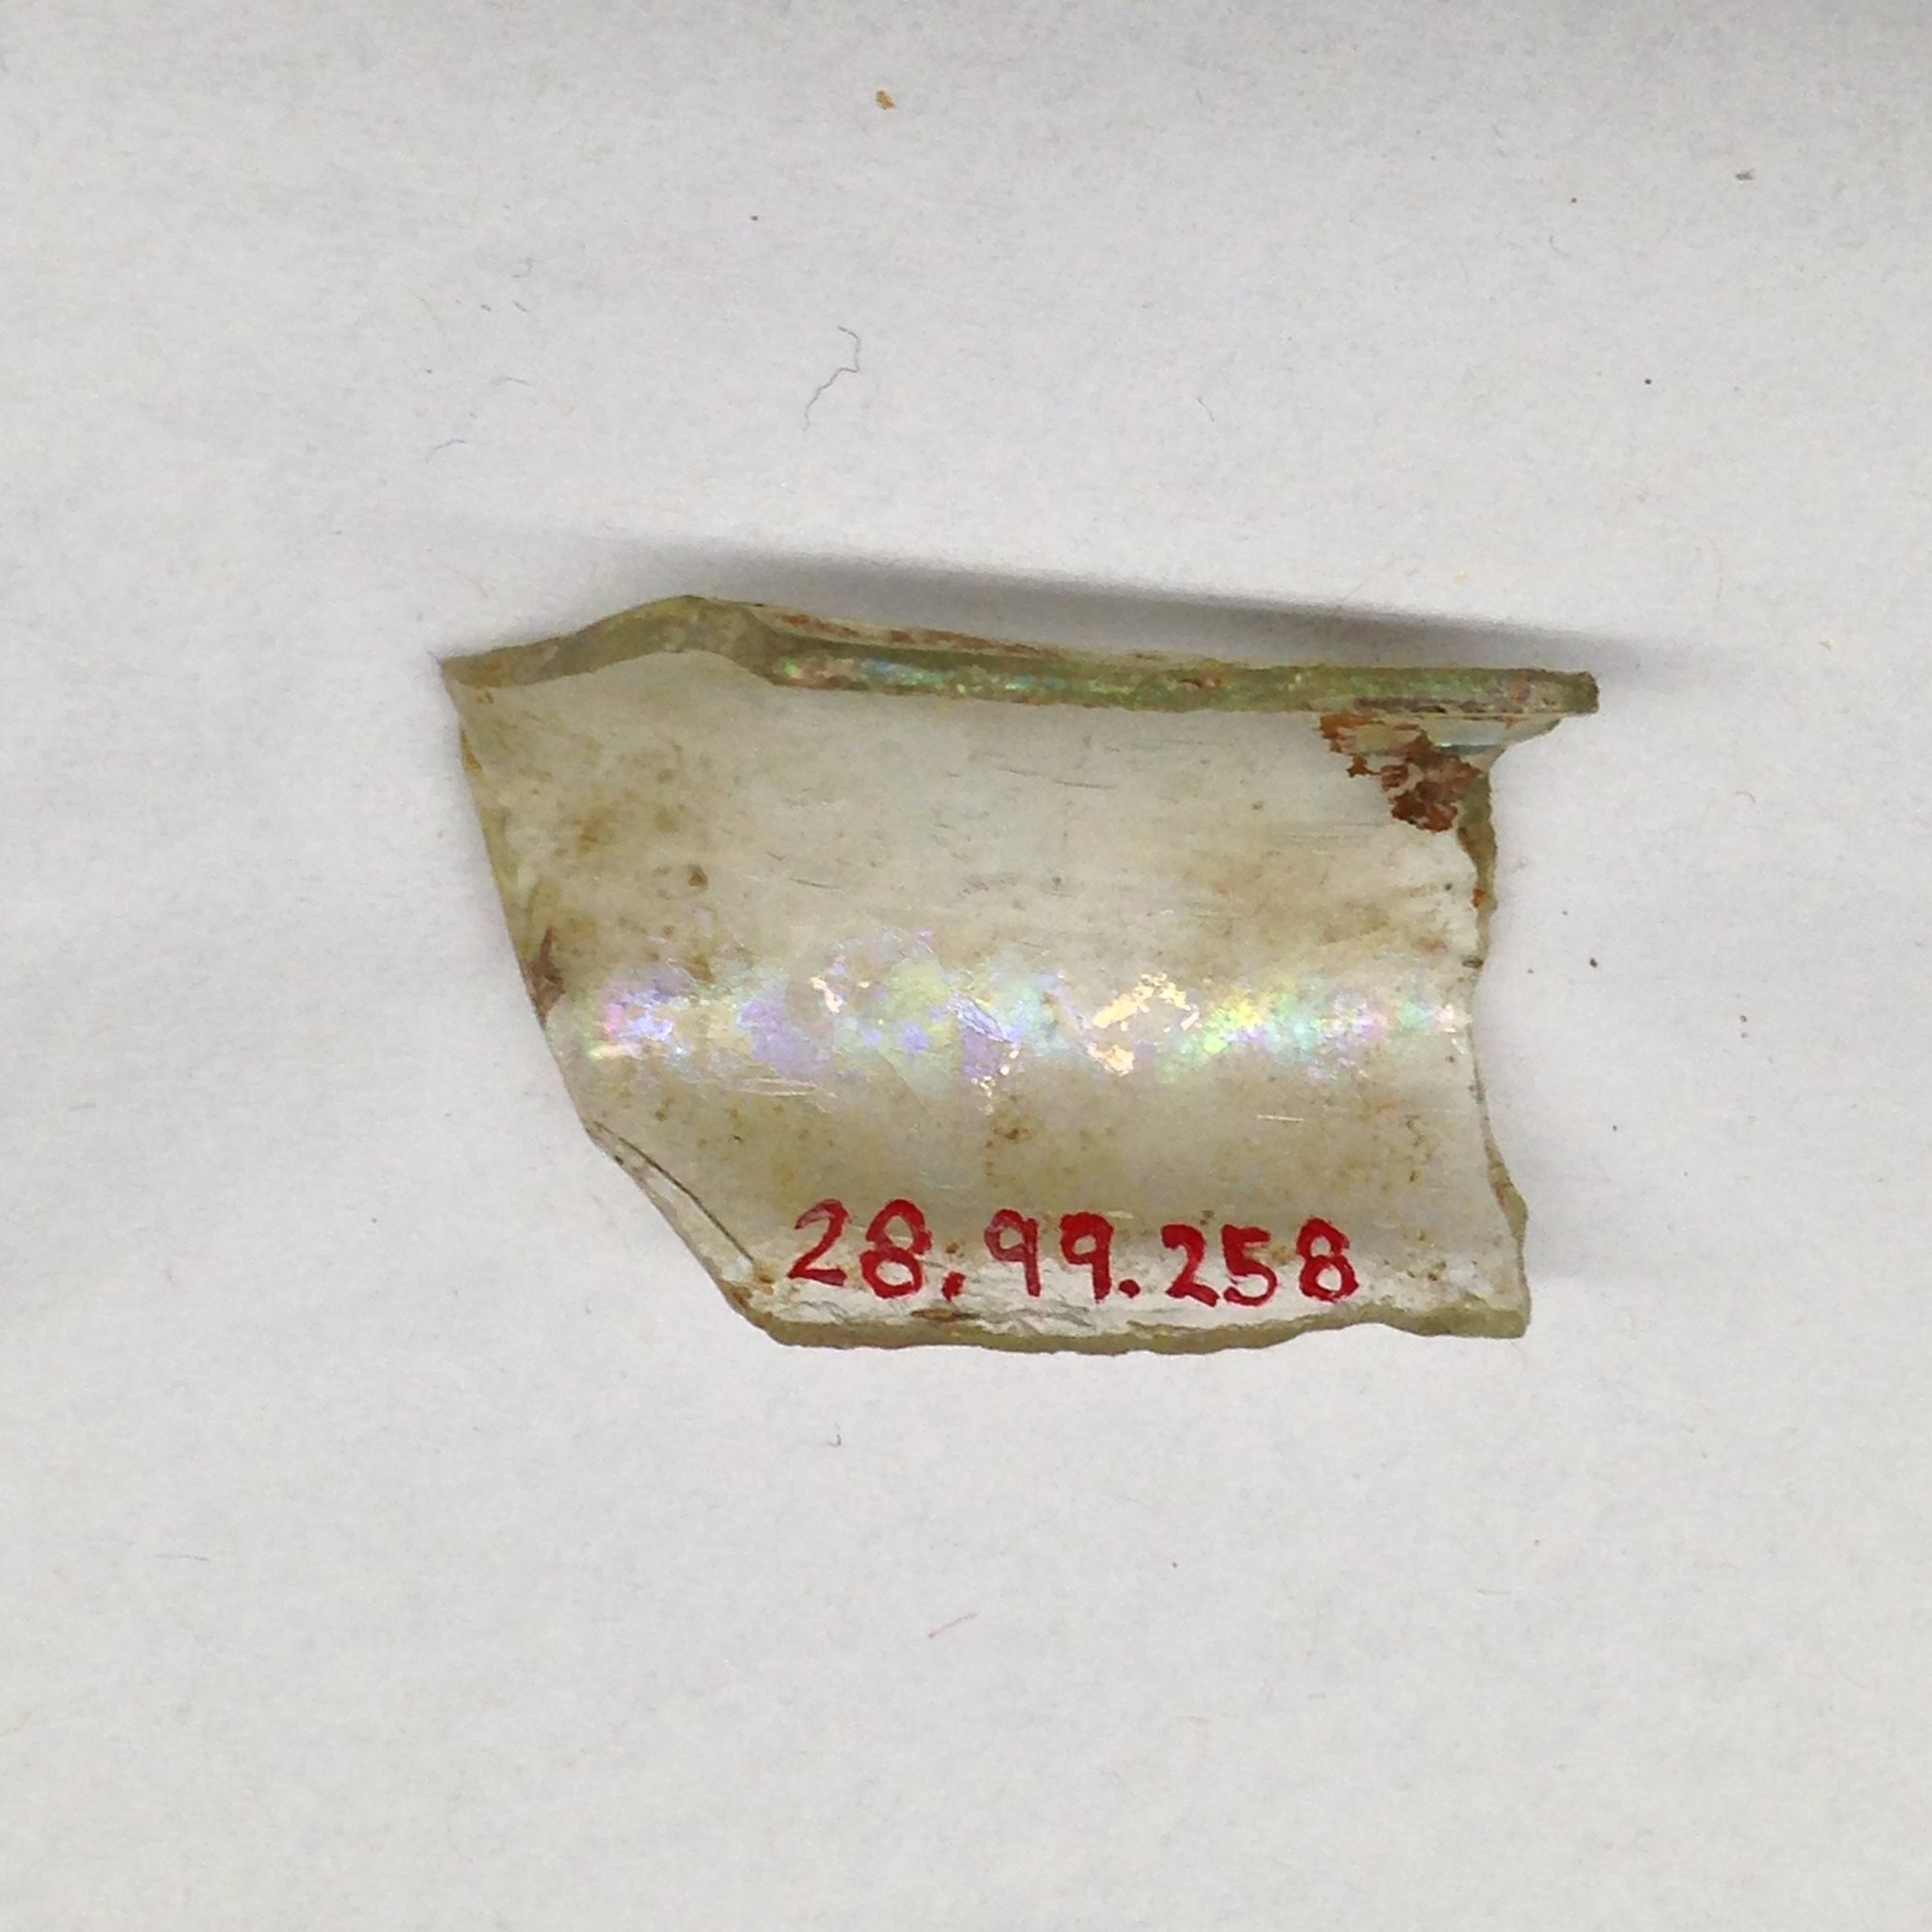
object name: fragment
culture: european or middle eastern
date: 1150-1250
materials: ceramic, glass